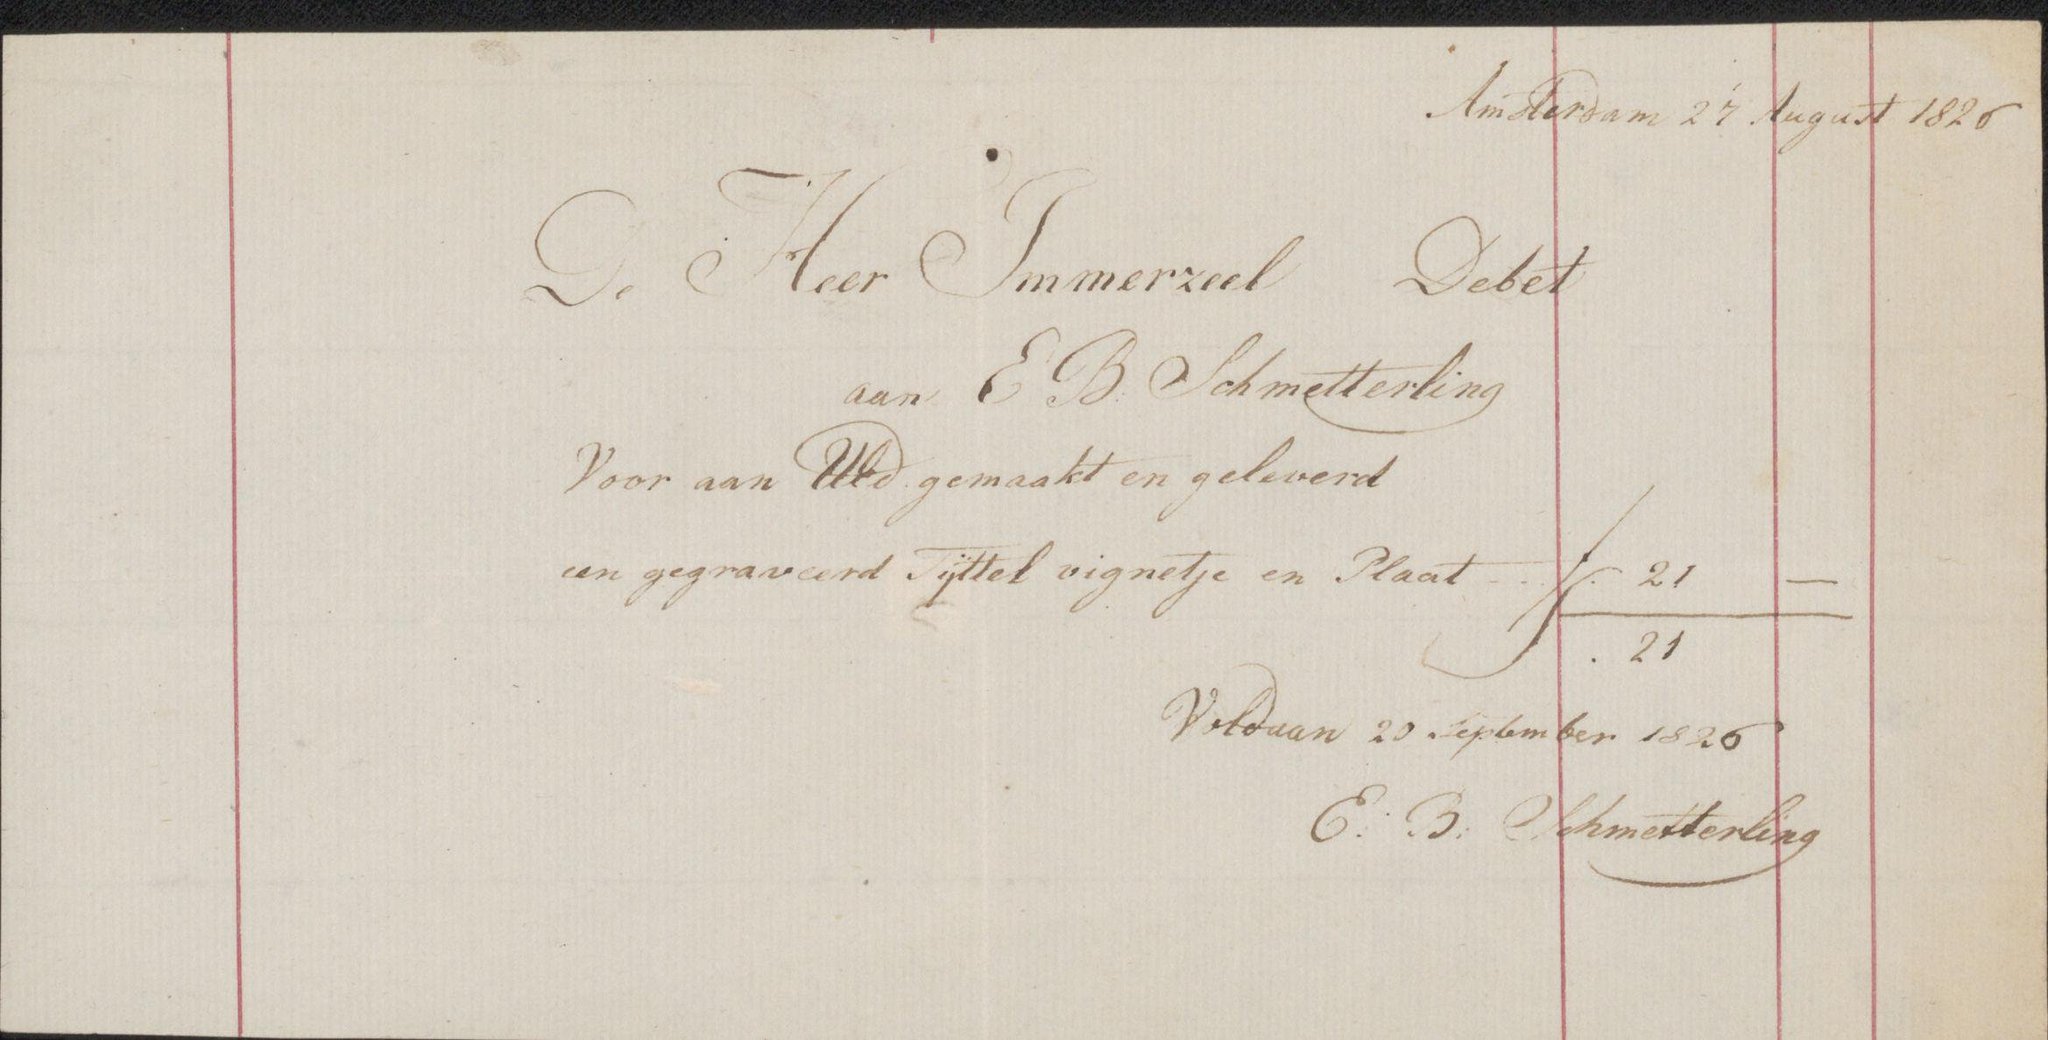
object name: ontvangstbewijs, kwitantie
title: Kwitantie voor Johannes Immerzeel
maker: elisabeth barbara schmetterling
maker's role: draughtsman, print maker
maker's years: 1804-1882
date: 1826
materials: ink, paper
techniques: pen, writing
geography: amsterdam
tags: publisher, johannes immerzeel, the graphic arts, money